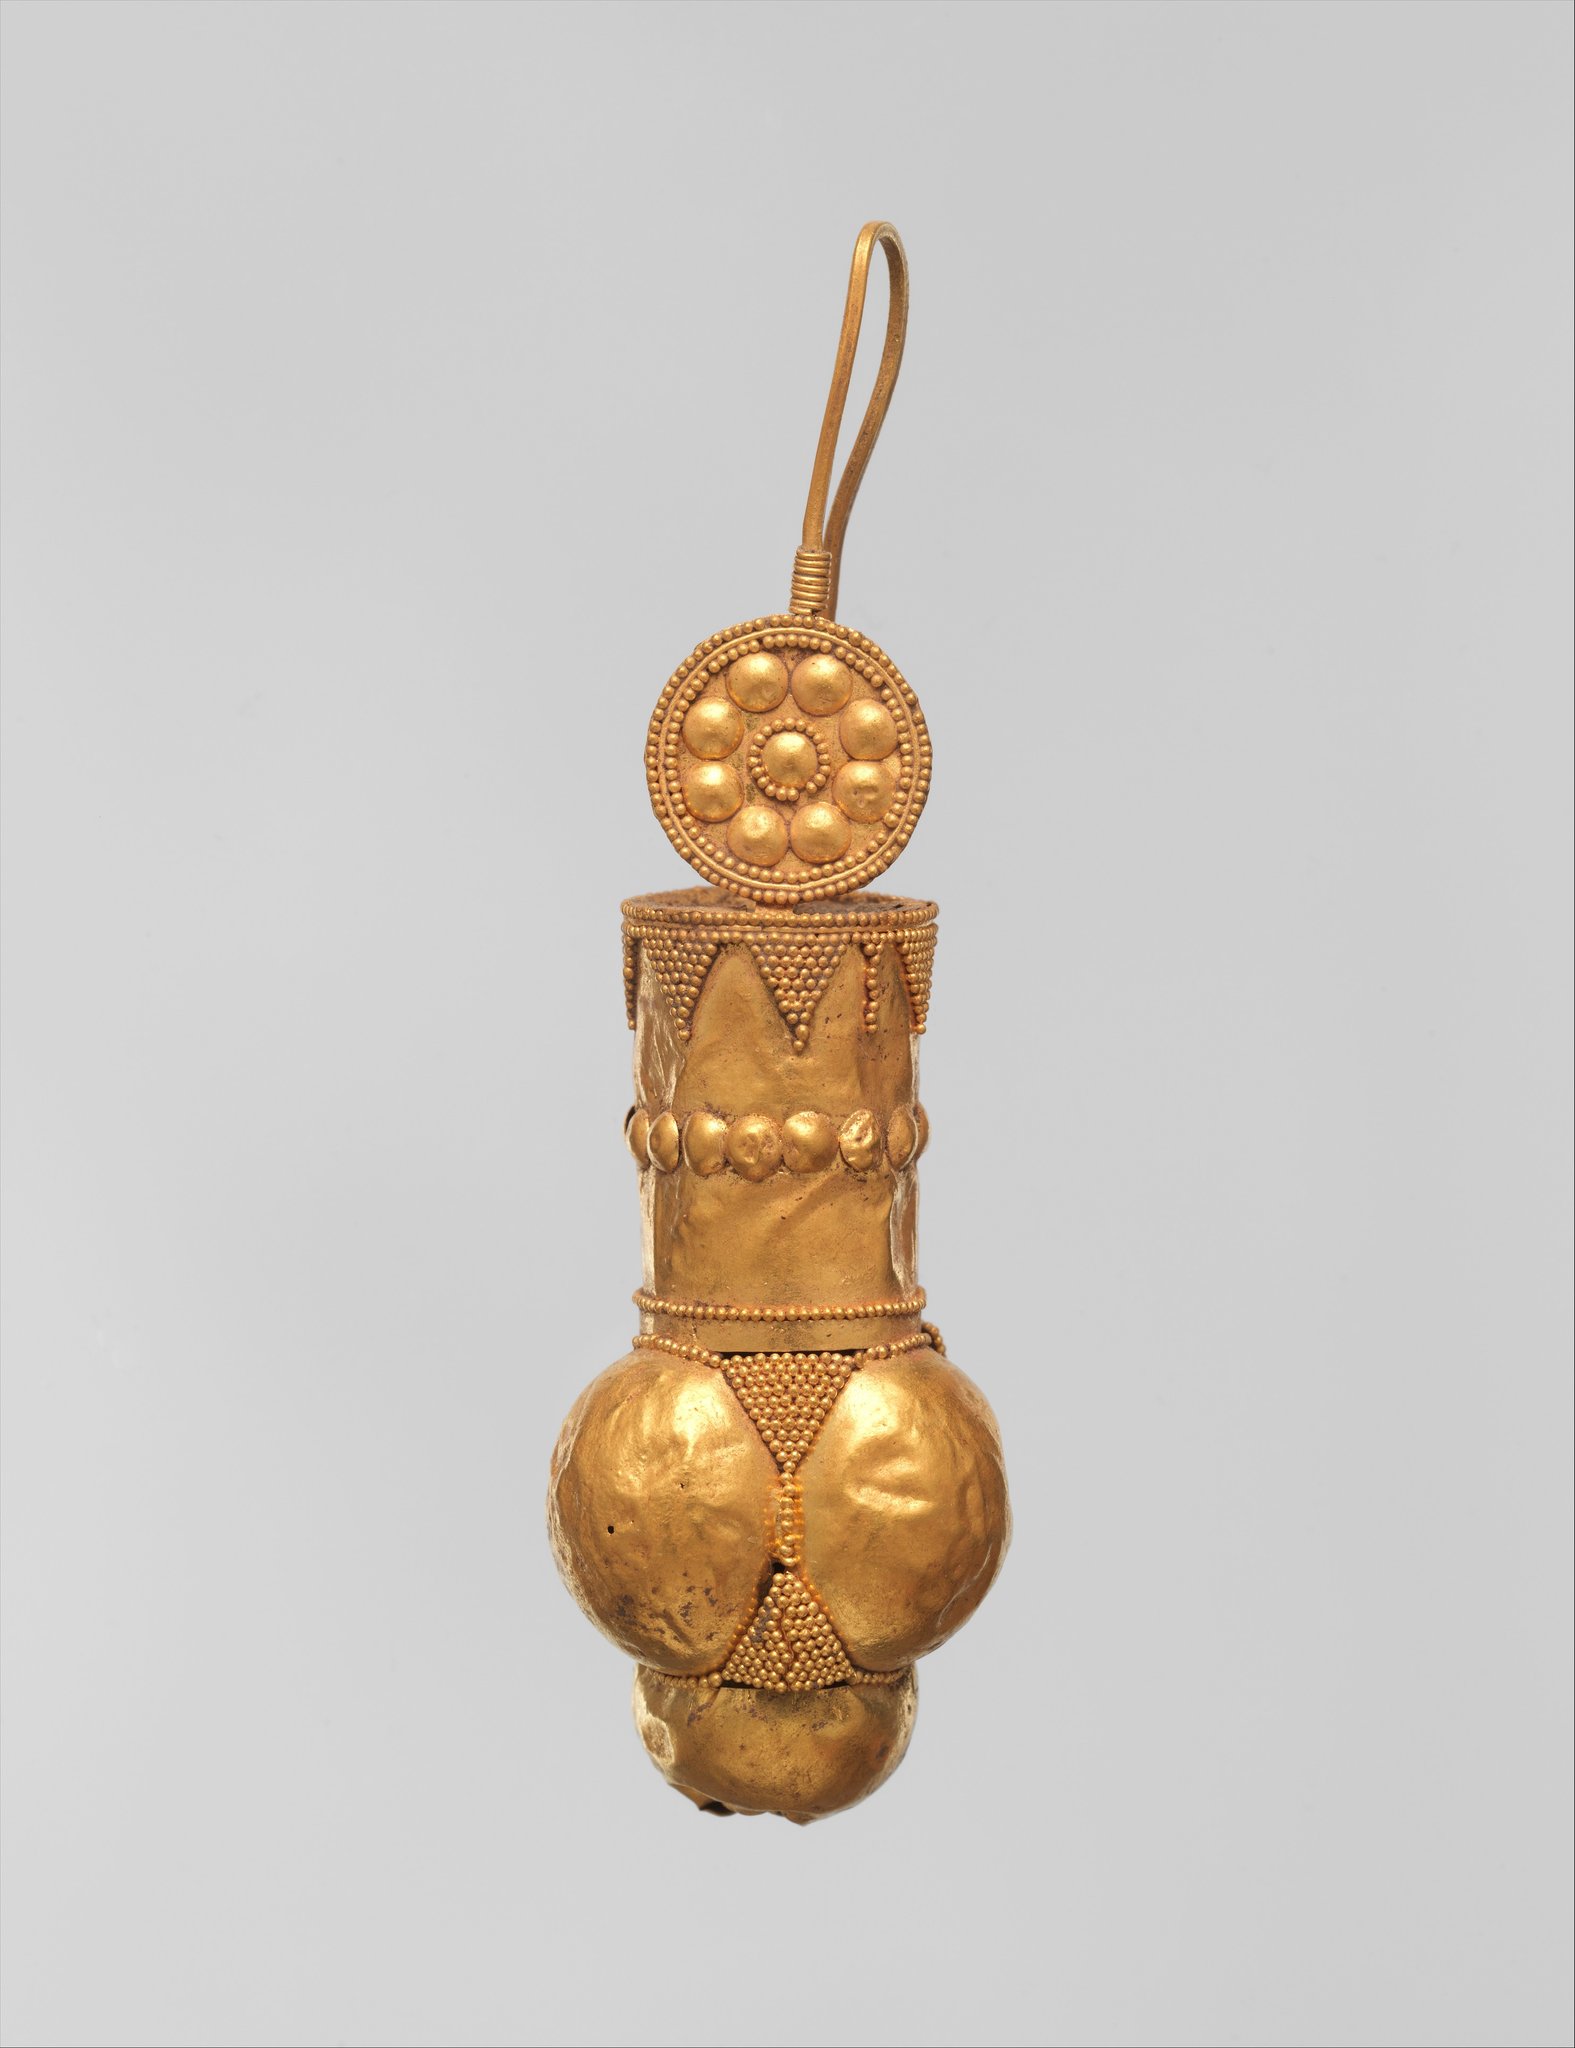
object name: earring, granulation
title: Earring with granulation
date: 200-30 BCE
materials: gold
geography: egypt